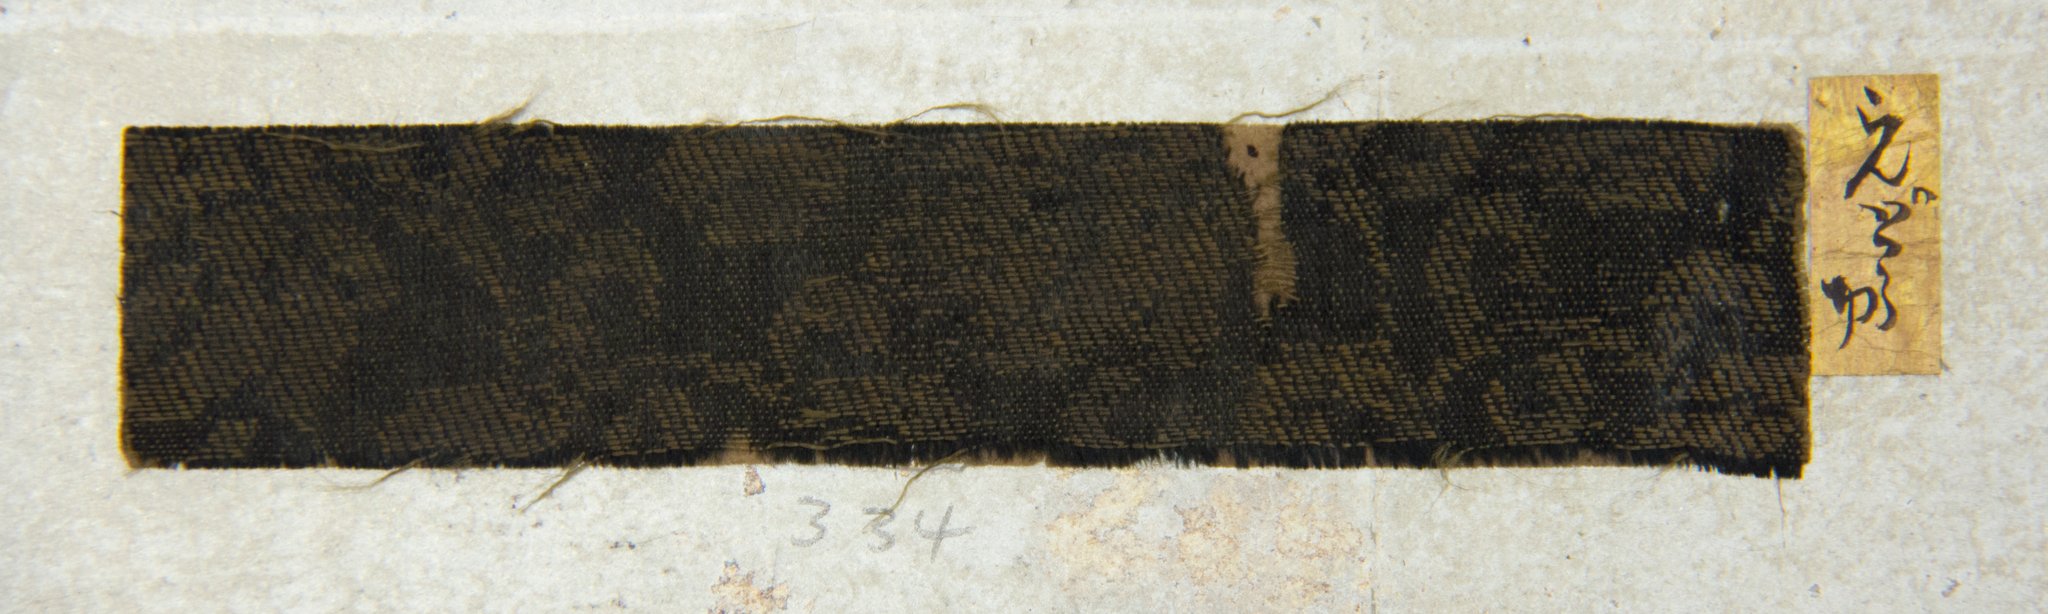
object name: piece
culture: chinese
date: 1601-1700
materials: silk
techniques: compound weave